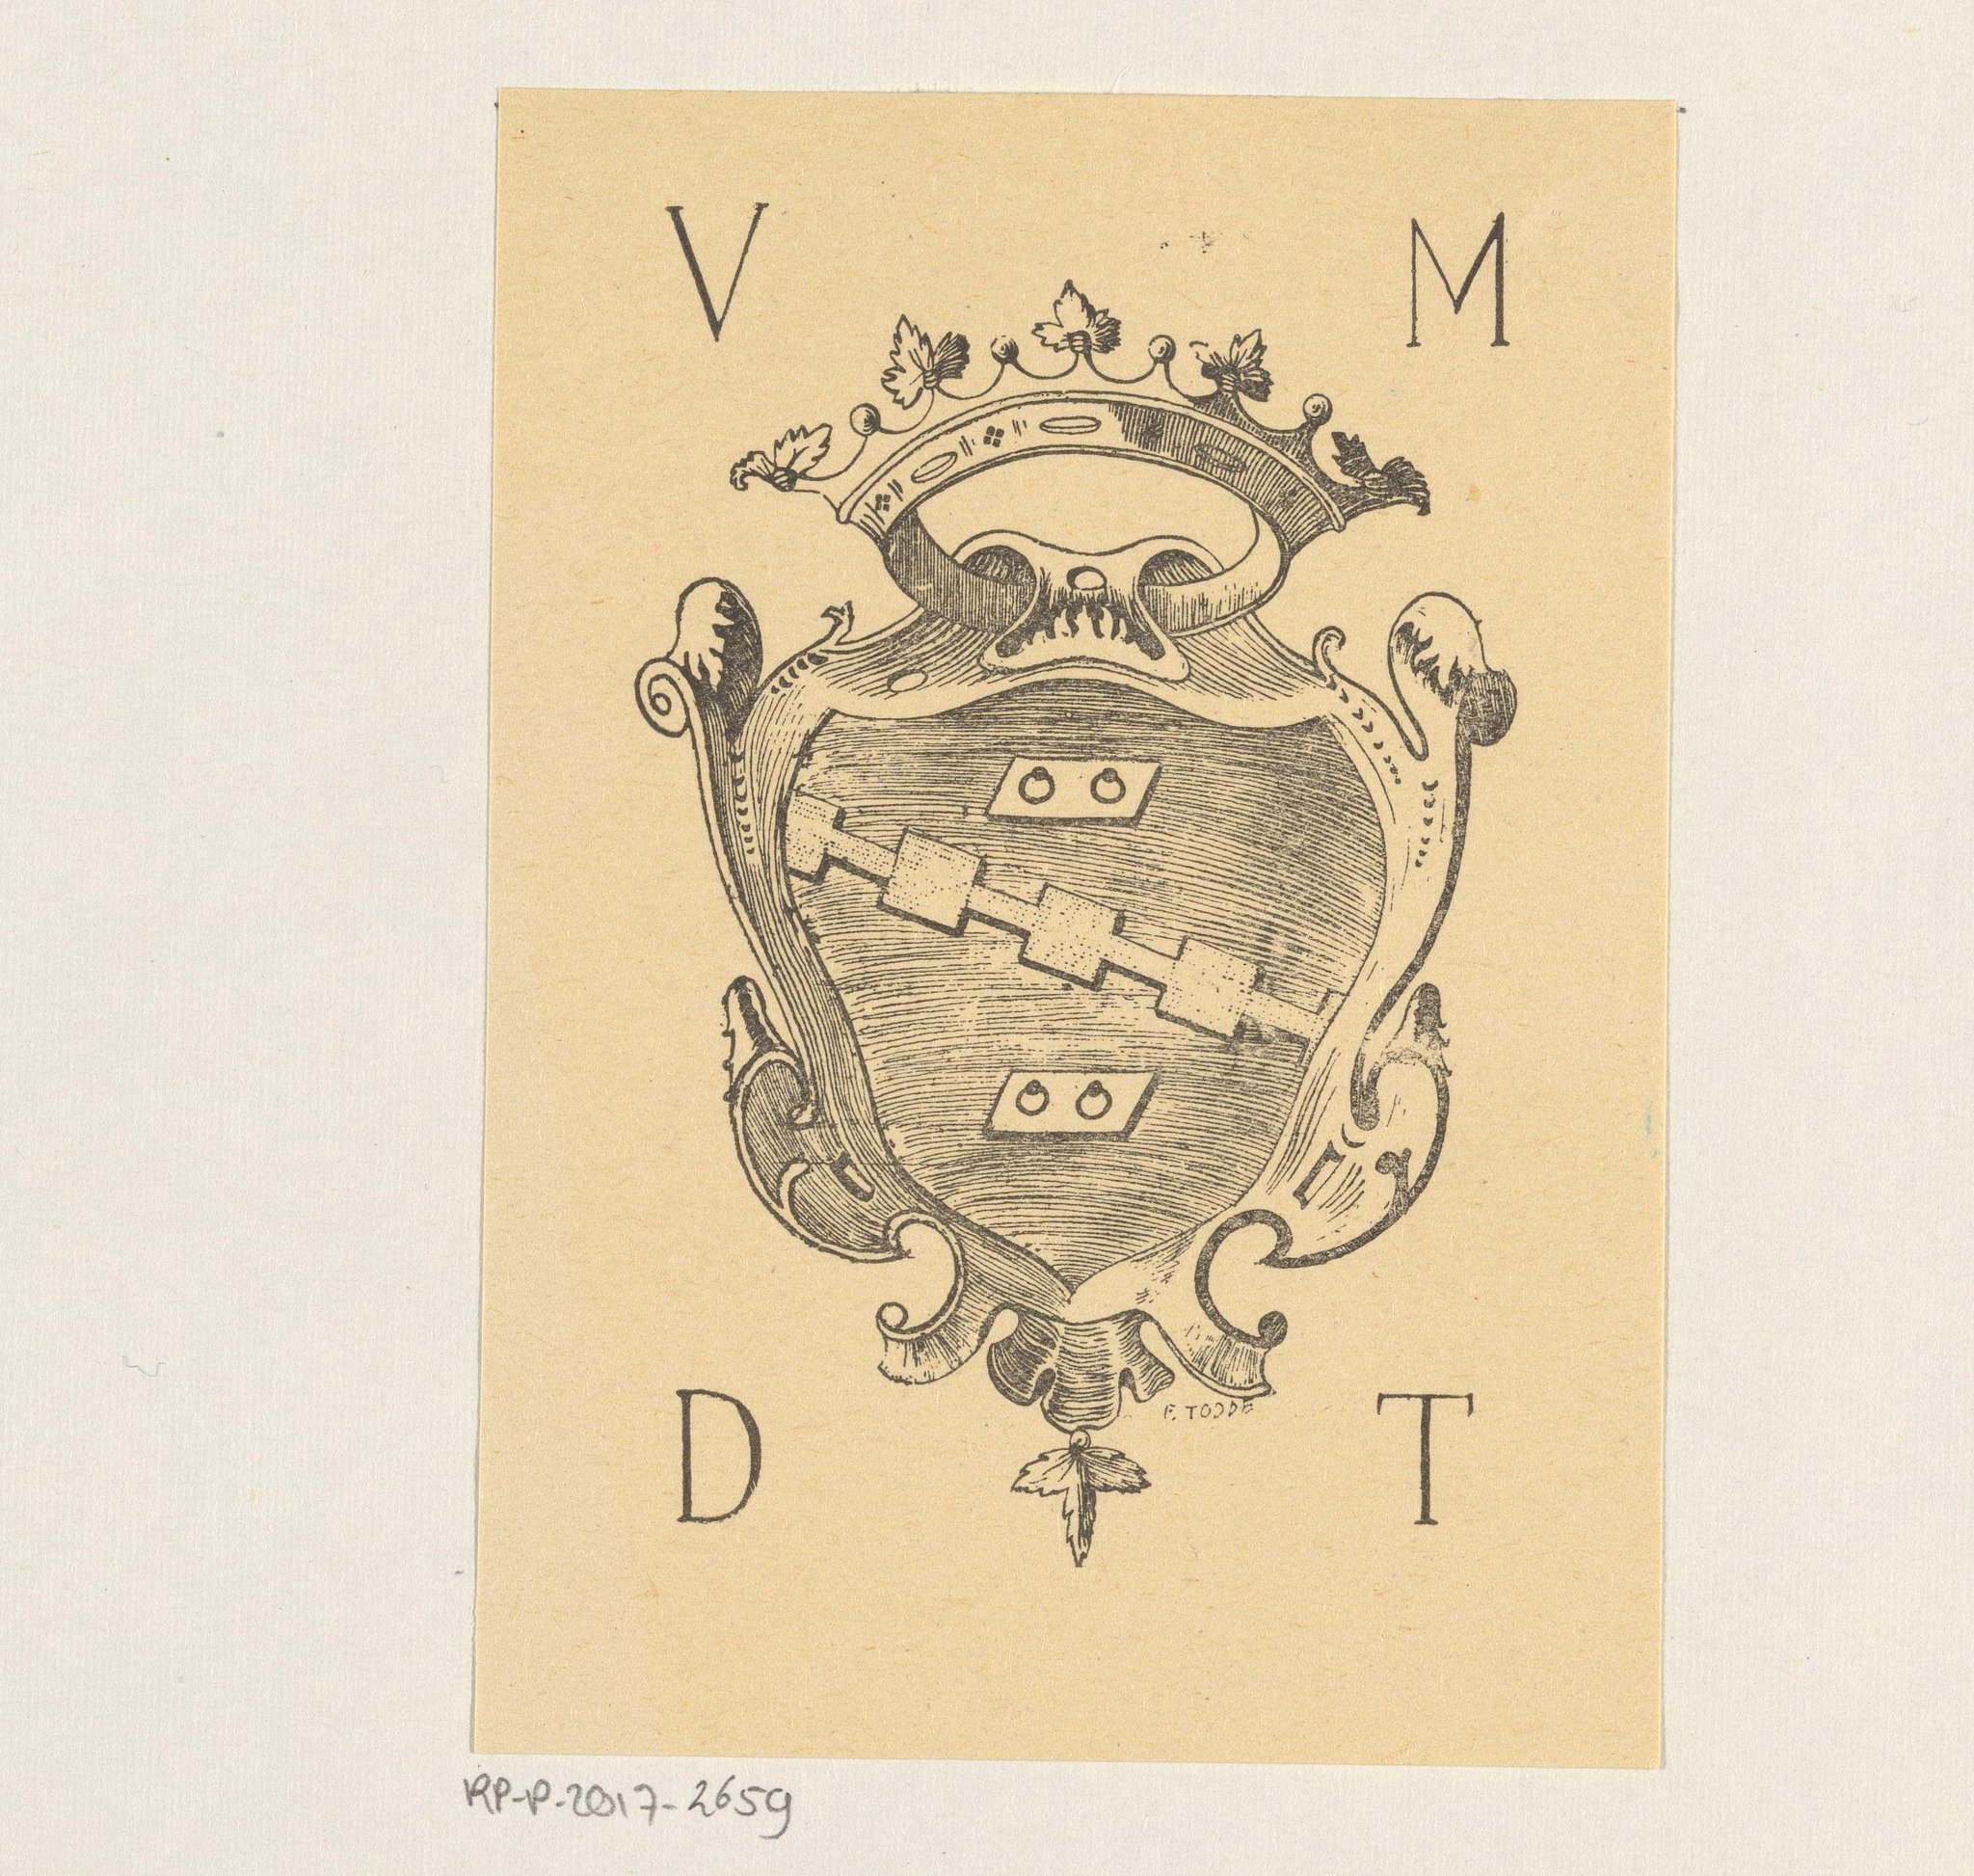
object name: bookplate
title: Ex libris van V.M.D.T.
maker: f. todde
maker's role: print maker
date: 1850-1950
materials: paper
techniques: lithograph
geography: italy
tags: armorial bearing, heraldry